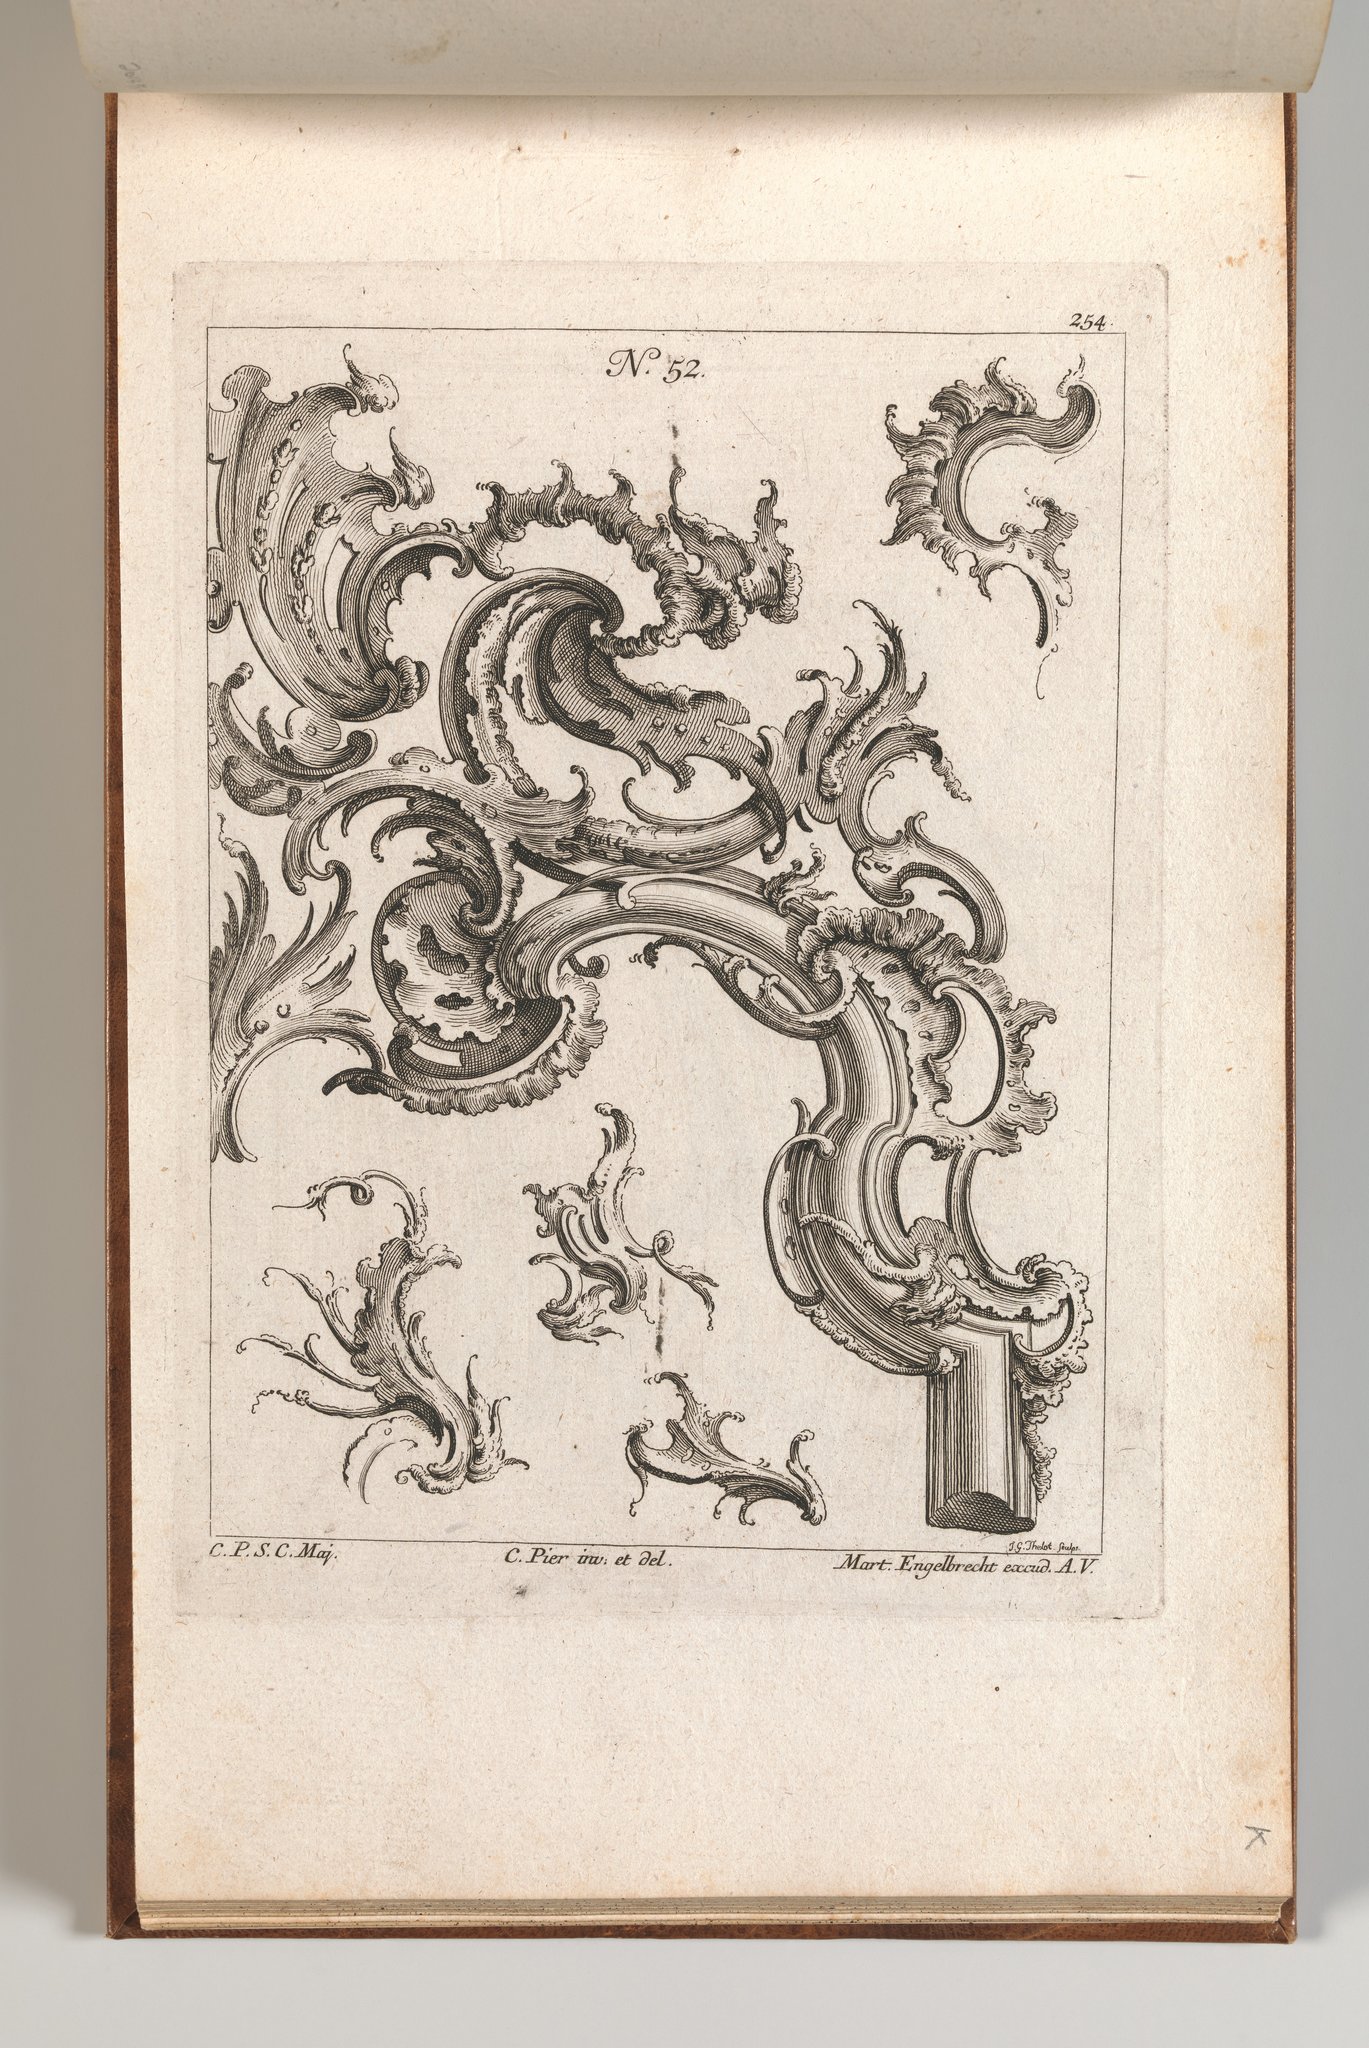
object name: album print ornament architecture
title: Various Designs for Rocaille Ornaments, Plate 1 from an Untitled Series of Rocaille Ornaments for Frames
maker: jacob gottlieb thelot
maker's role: engraver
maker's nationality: central european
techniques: etching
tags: ornament